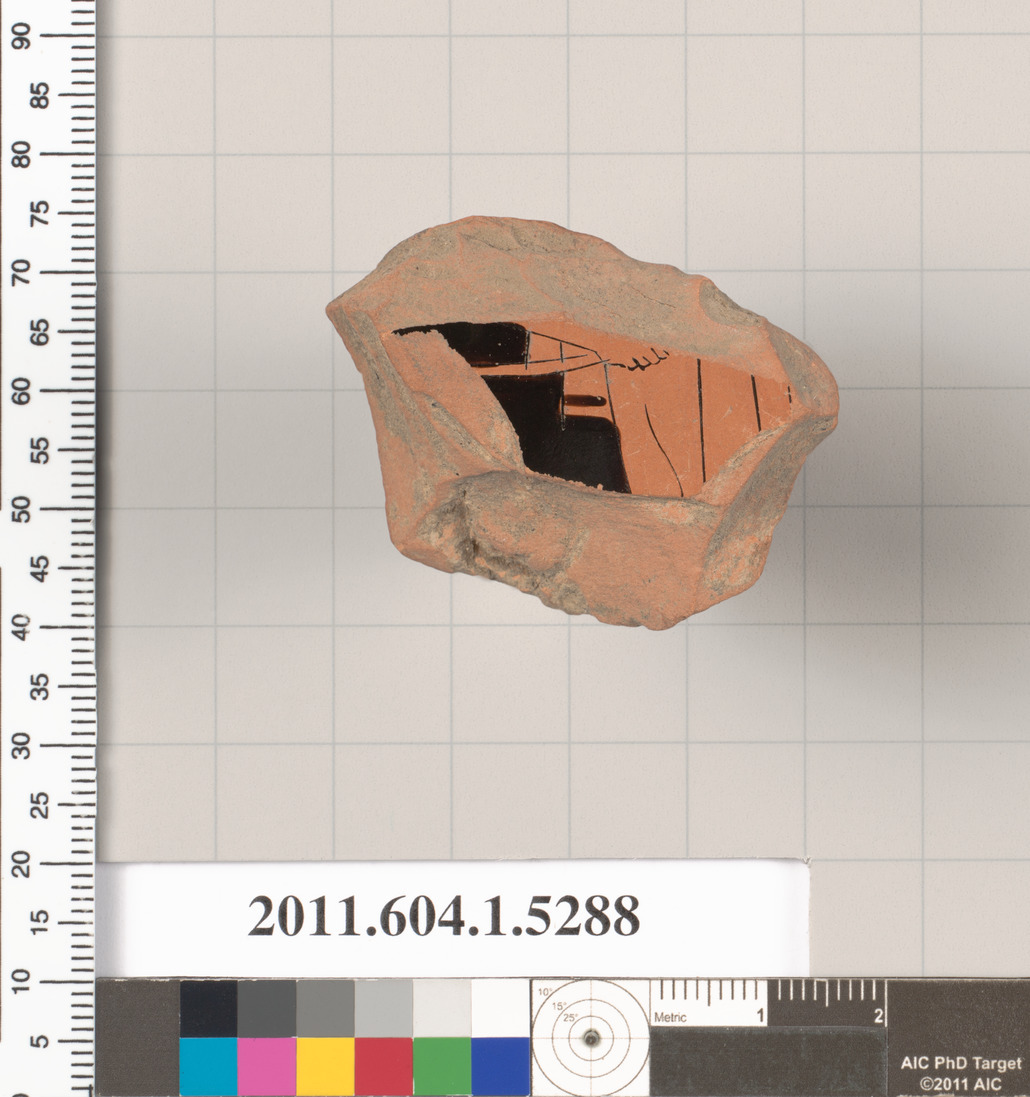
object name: kylix fragment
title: Terracotta fragment of a kylix (drinking cup)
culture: greek, attic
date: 475-451 BCE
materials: terracotta